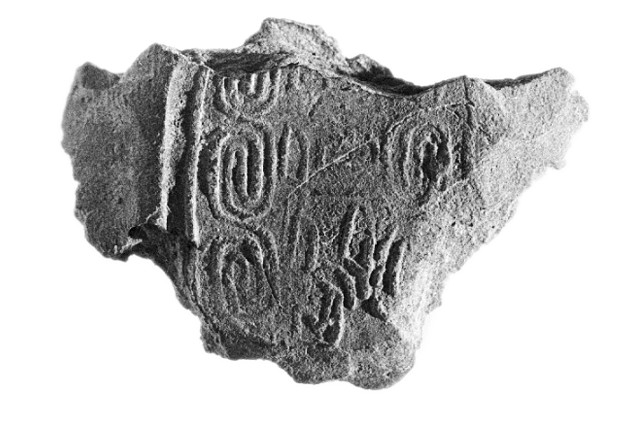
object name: sealing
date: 1981-1640 BCE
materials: mud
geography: egypt